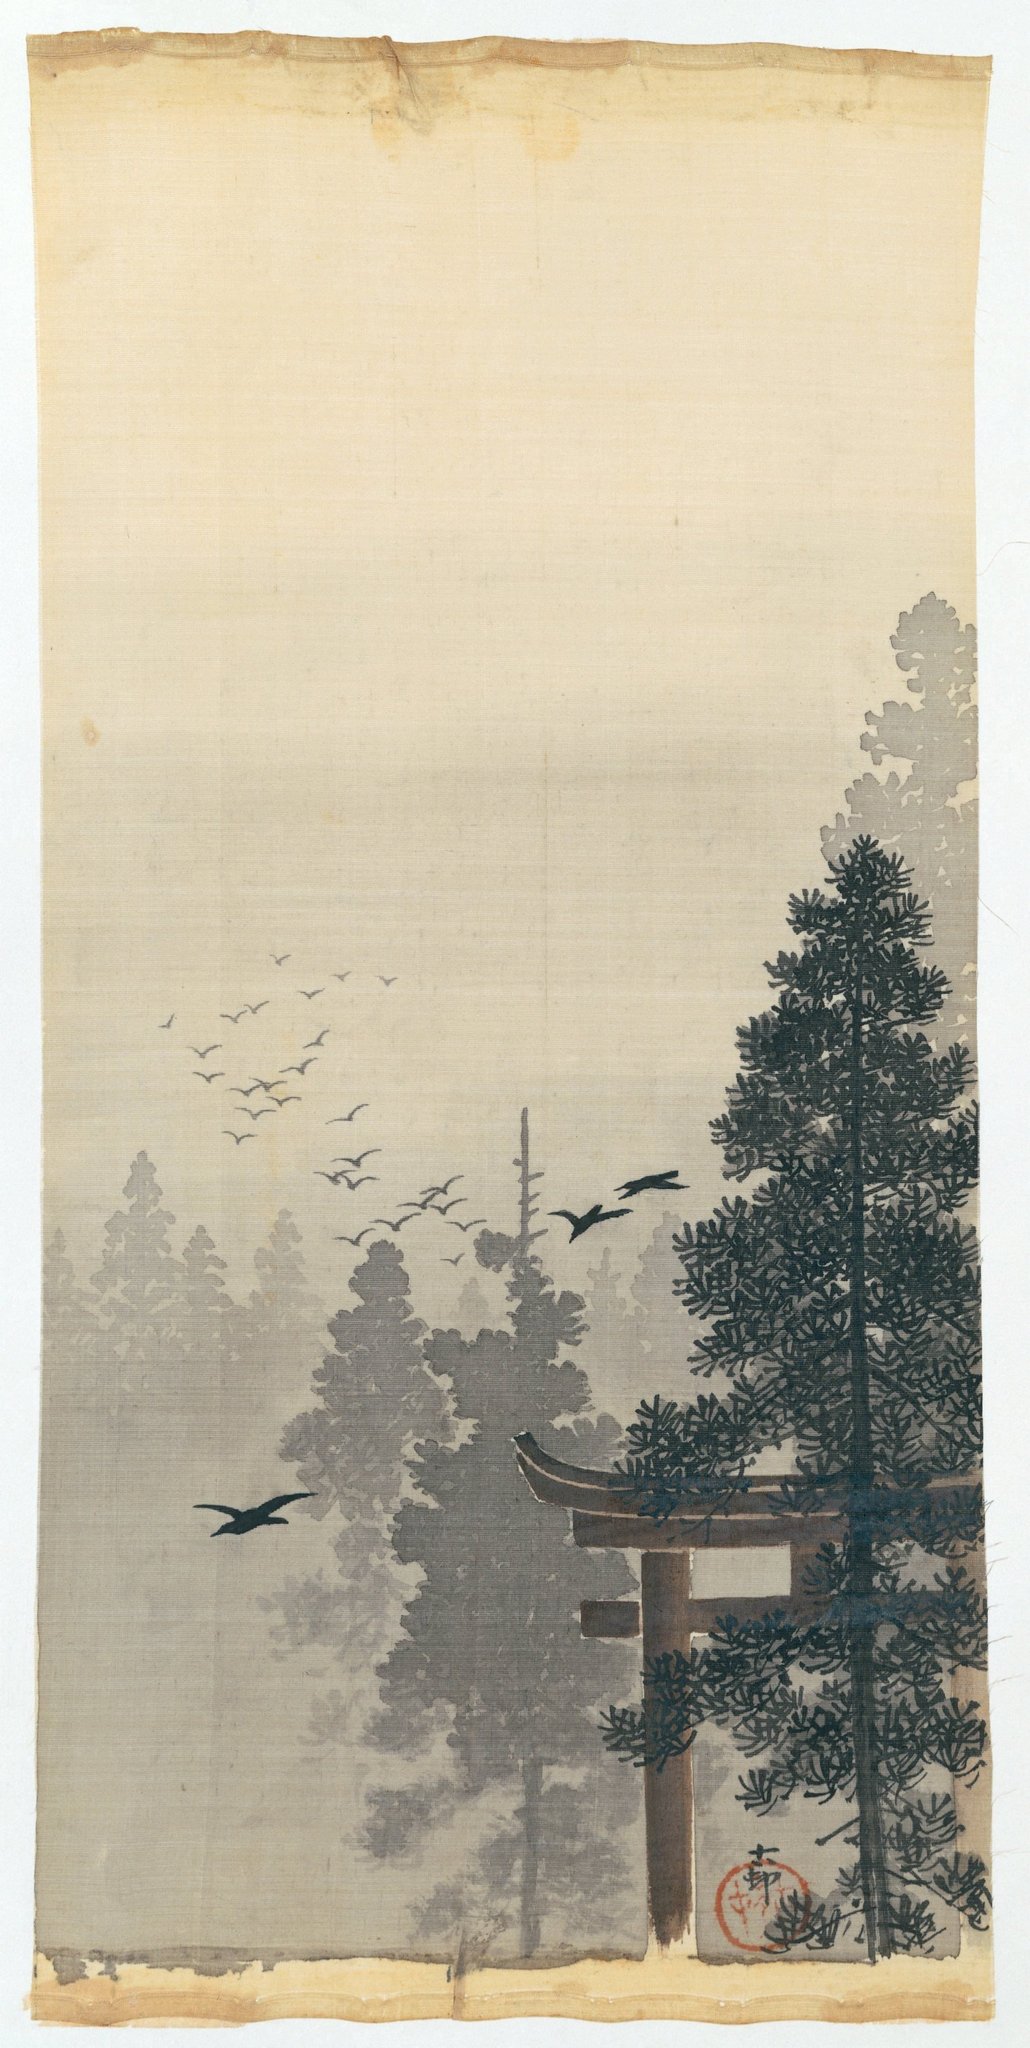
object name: painting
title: Landschap met zwerm vogels en torii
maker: ohara koson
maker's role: print maker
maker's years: 1877-1945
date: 1887-1945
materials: silk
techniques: brush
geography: japan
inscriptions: signature: ‘Koson’, seal: ‘Koson’, seal: ‘Koson’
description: Een landschap met een zwerm vogels, een tempelpoort (torii) temidden van een silhouet van naaldbomen.